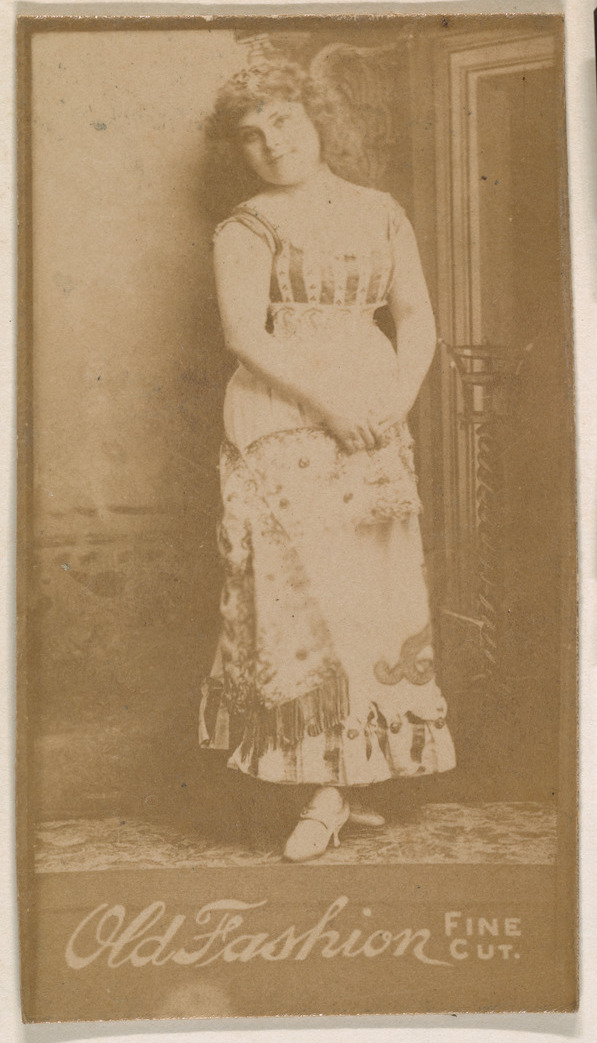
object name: photograph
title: Actress standing with hands clasped at waist, from the Actresses series (N664) promoting Old Fashion Fine Cut Tobacco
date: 1888-1890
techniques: albumen silver print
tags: portraits,women,actresses